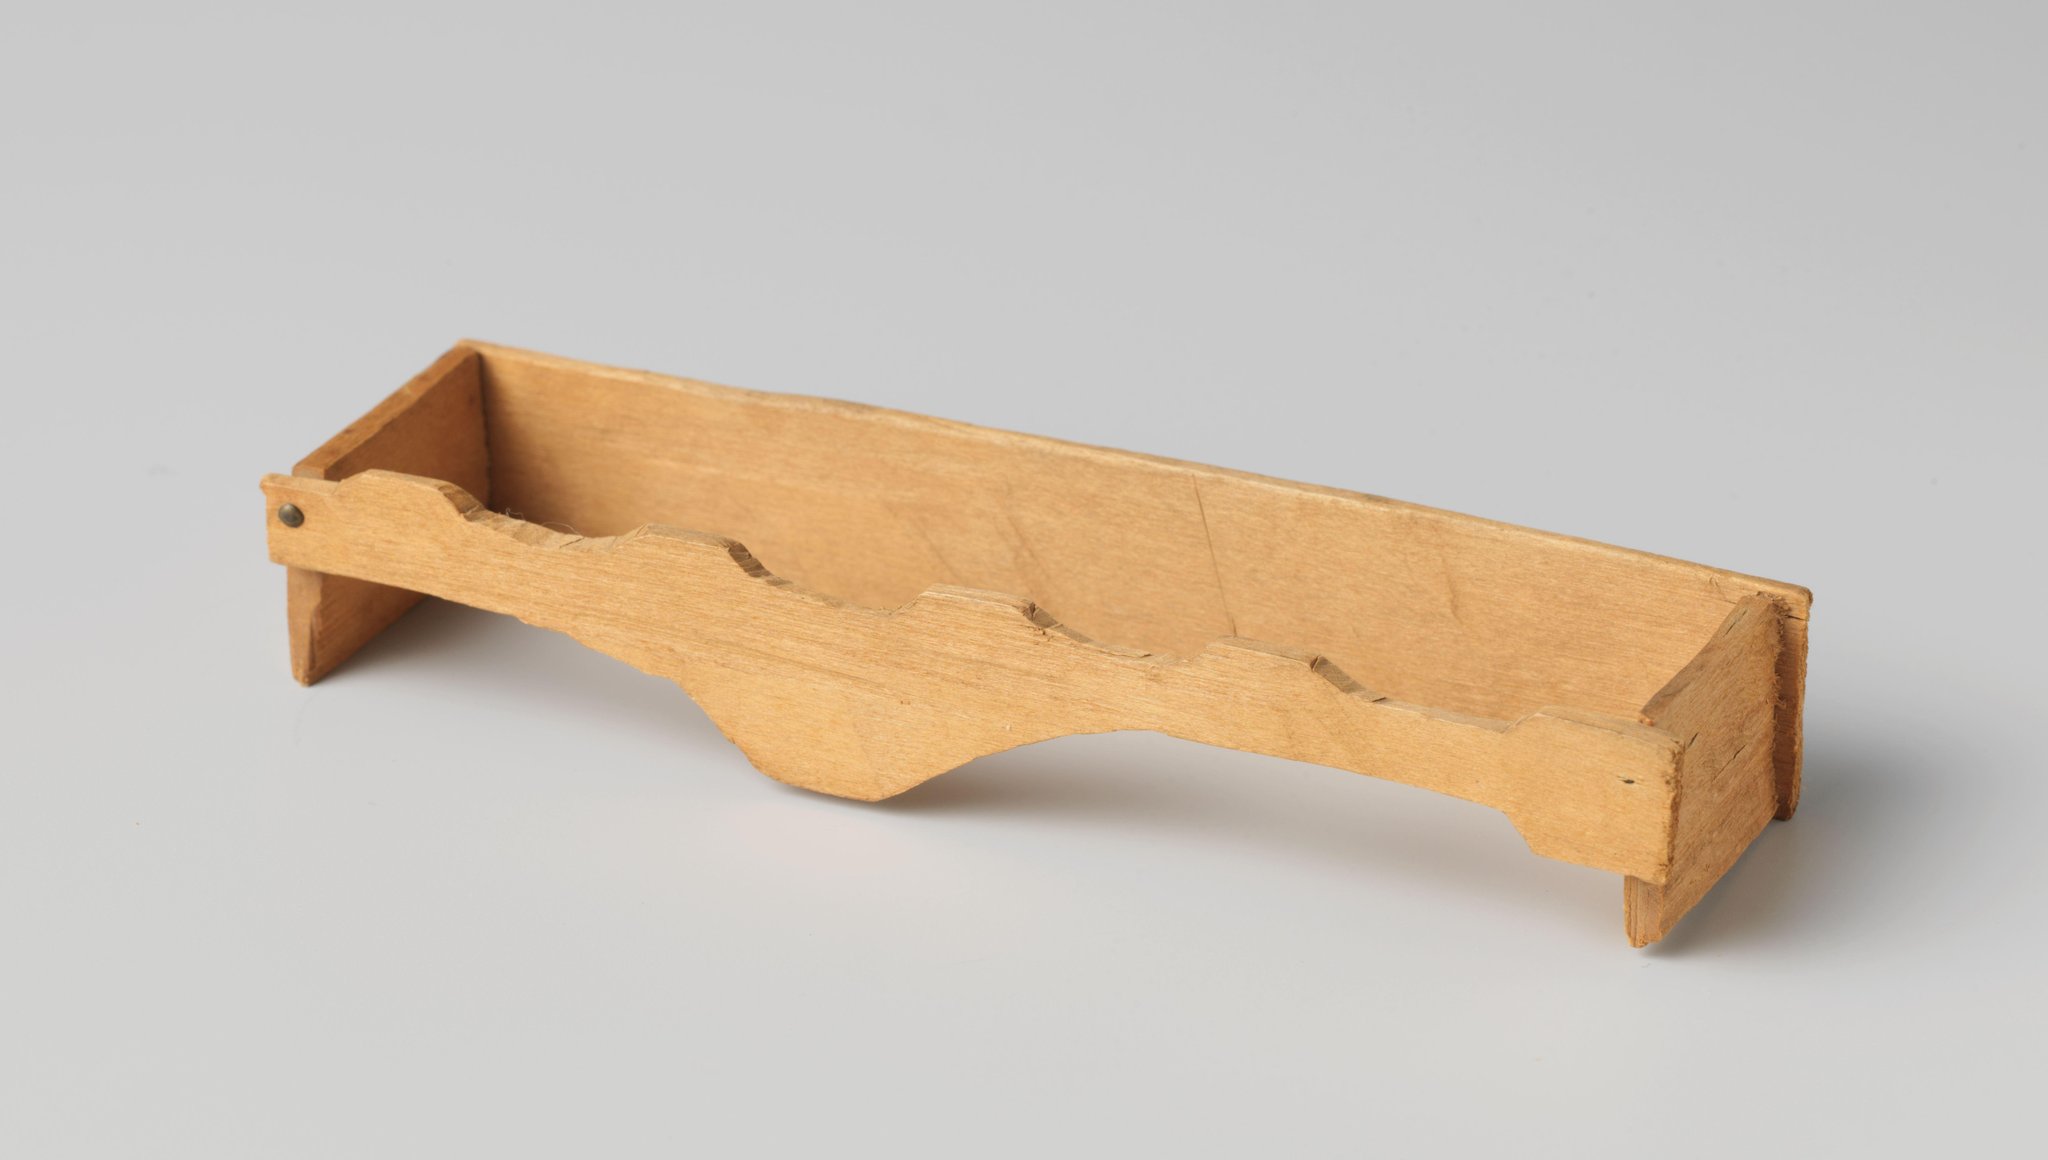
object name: gantry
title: Stelling met plaats voor vier vaten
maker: Anonymous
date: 1700-1799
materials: wood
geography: amsterdam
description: Een stelling van lindehout, met plaats voor vier vaten.